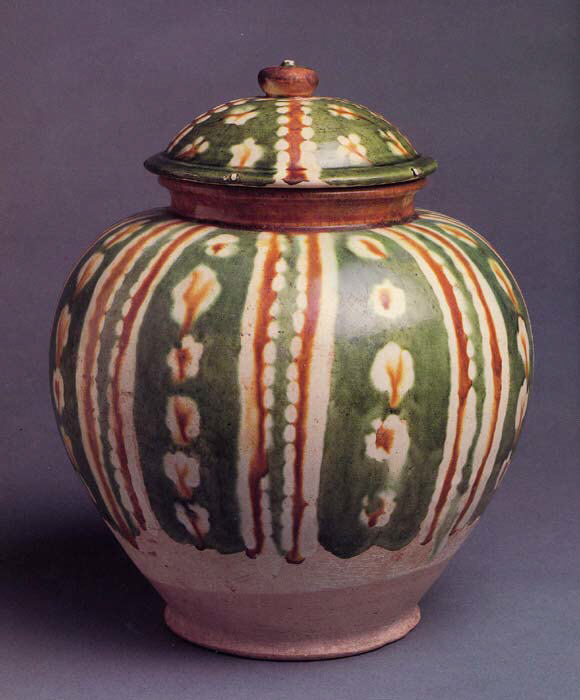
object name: covered jar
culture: chinese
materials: earthenware, glaze